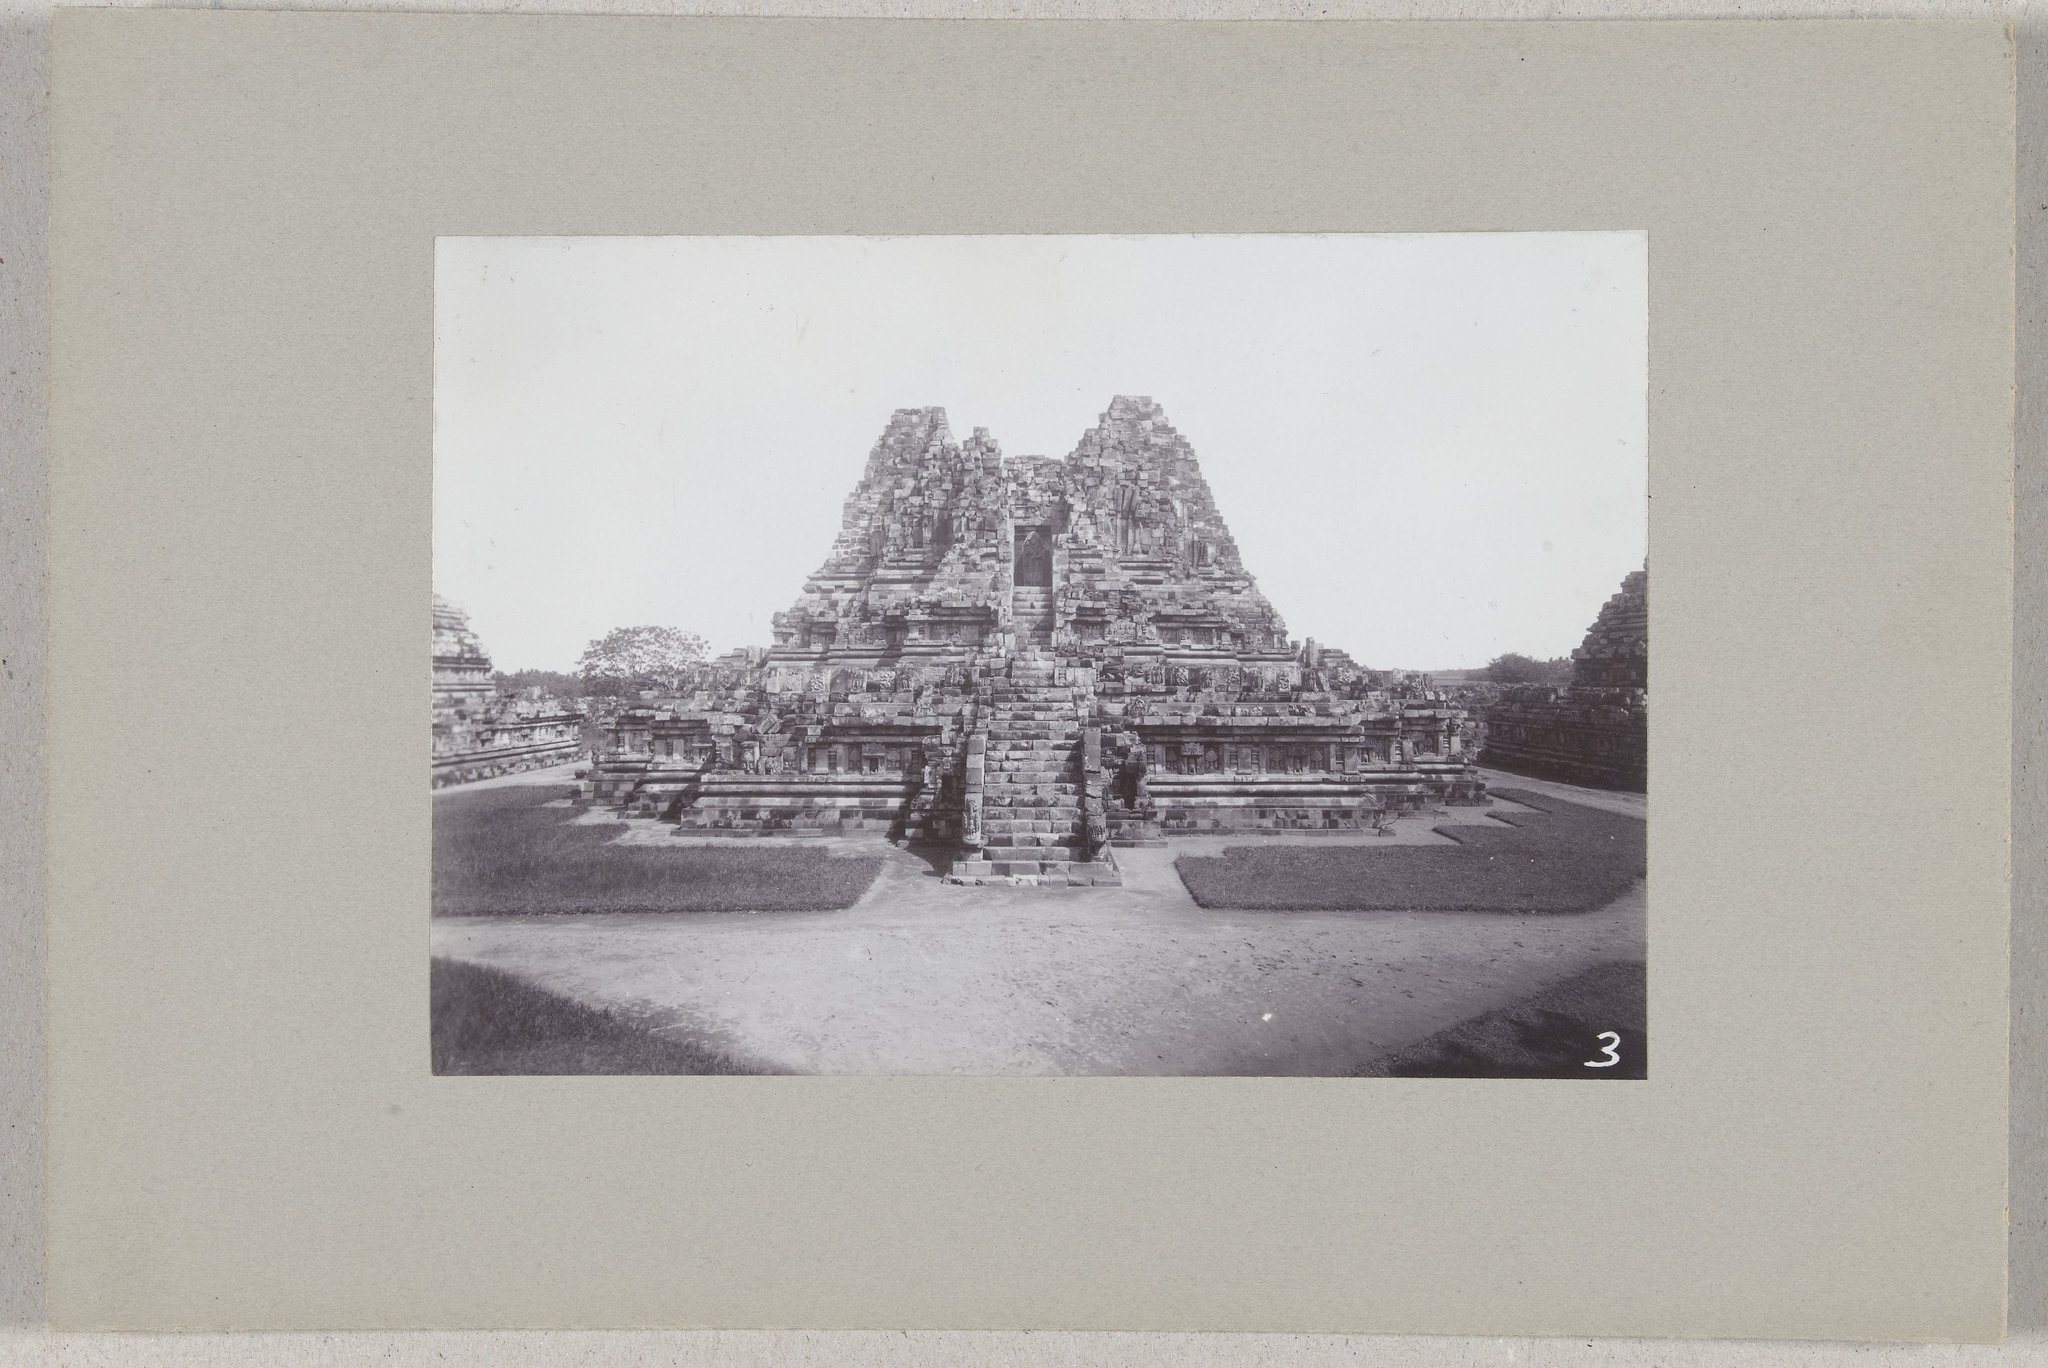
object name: photograph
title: Tempel van Prambanan bij Jogyakarta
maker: Anonymous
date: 1895-1915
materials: cardboard, paper, photographic support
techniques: gelatin silver print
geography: jogjakarta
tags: indonesia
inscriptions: annotation: ‘84a Prambanan-tempels (tempel a) / c a d / b’, number: ‘3’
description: Tempel van Prambanan bij Jogyakarta, Nederlands-Indië